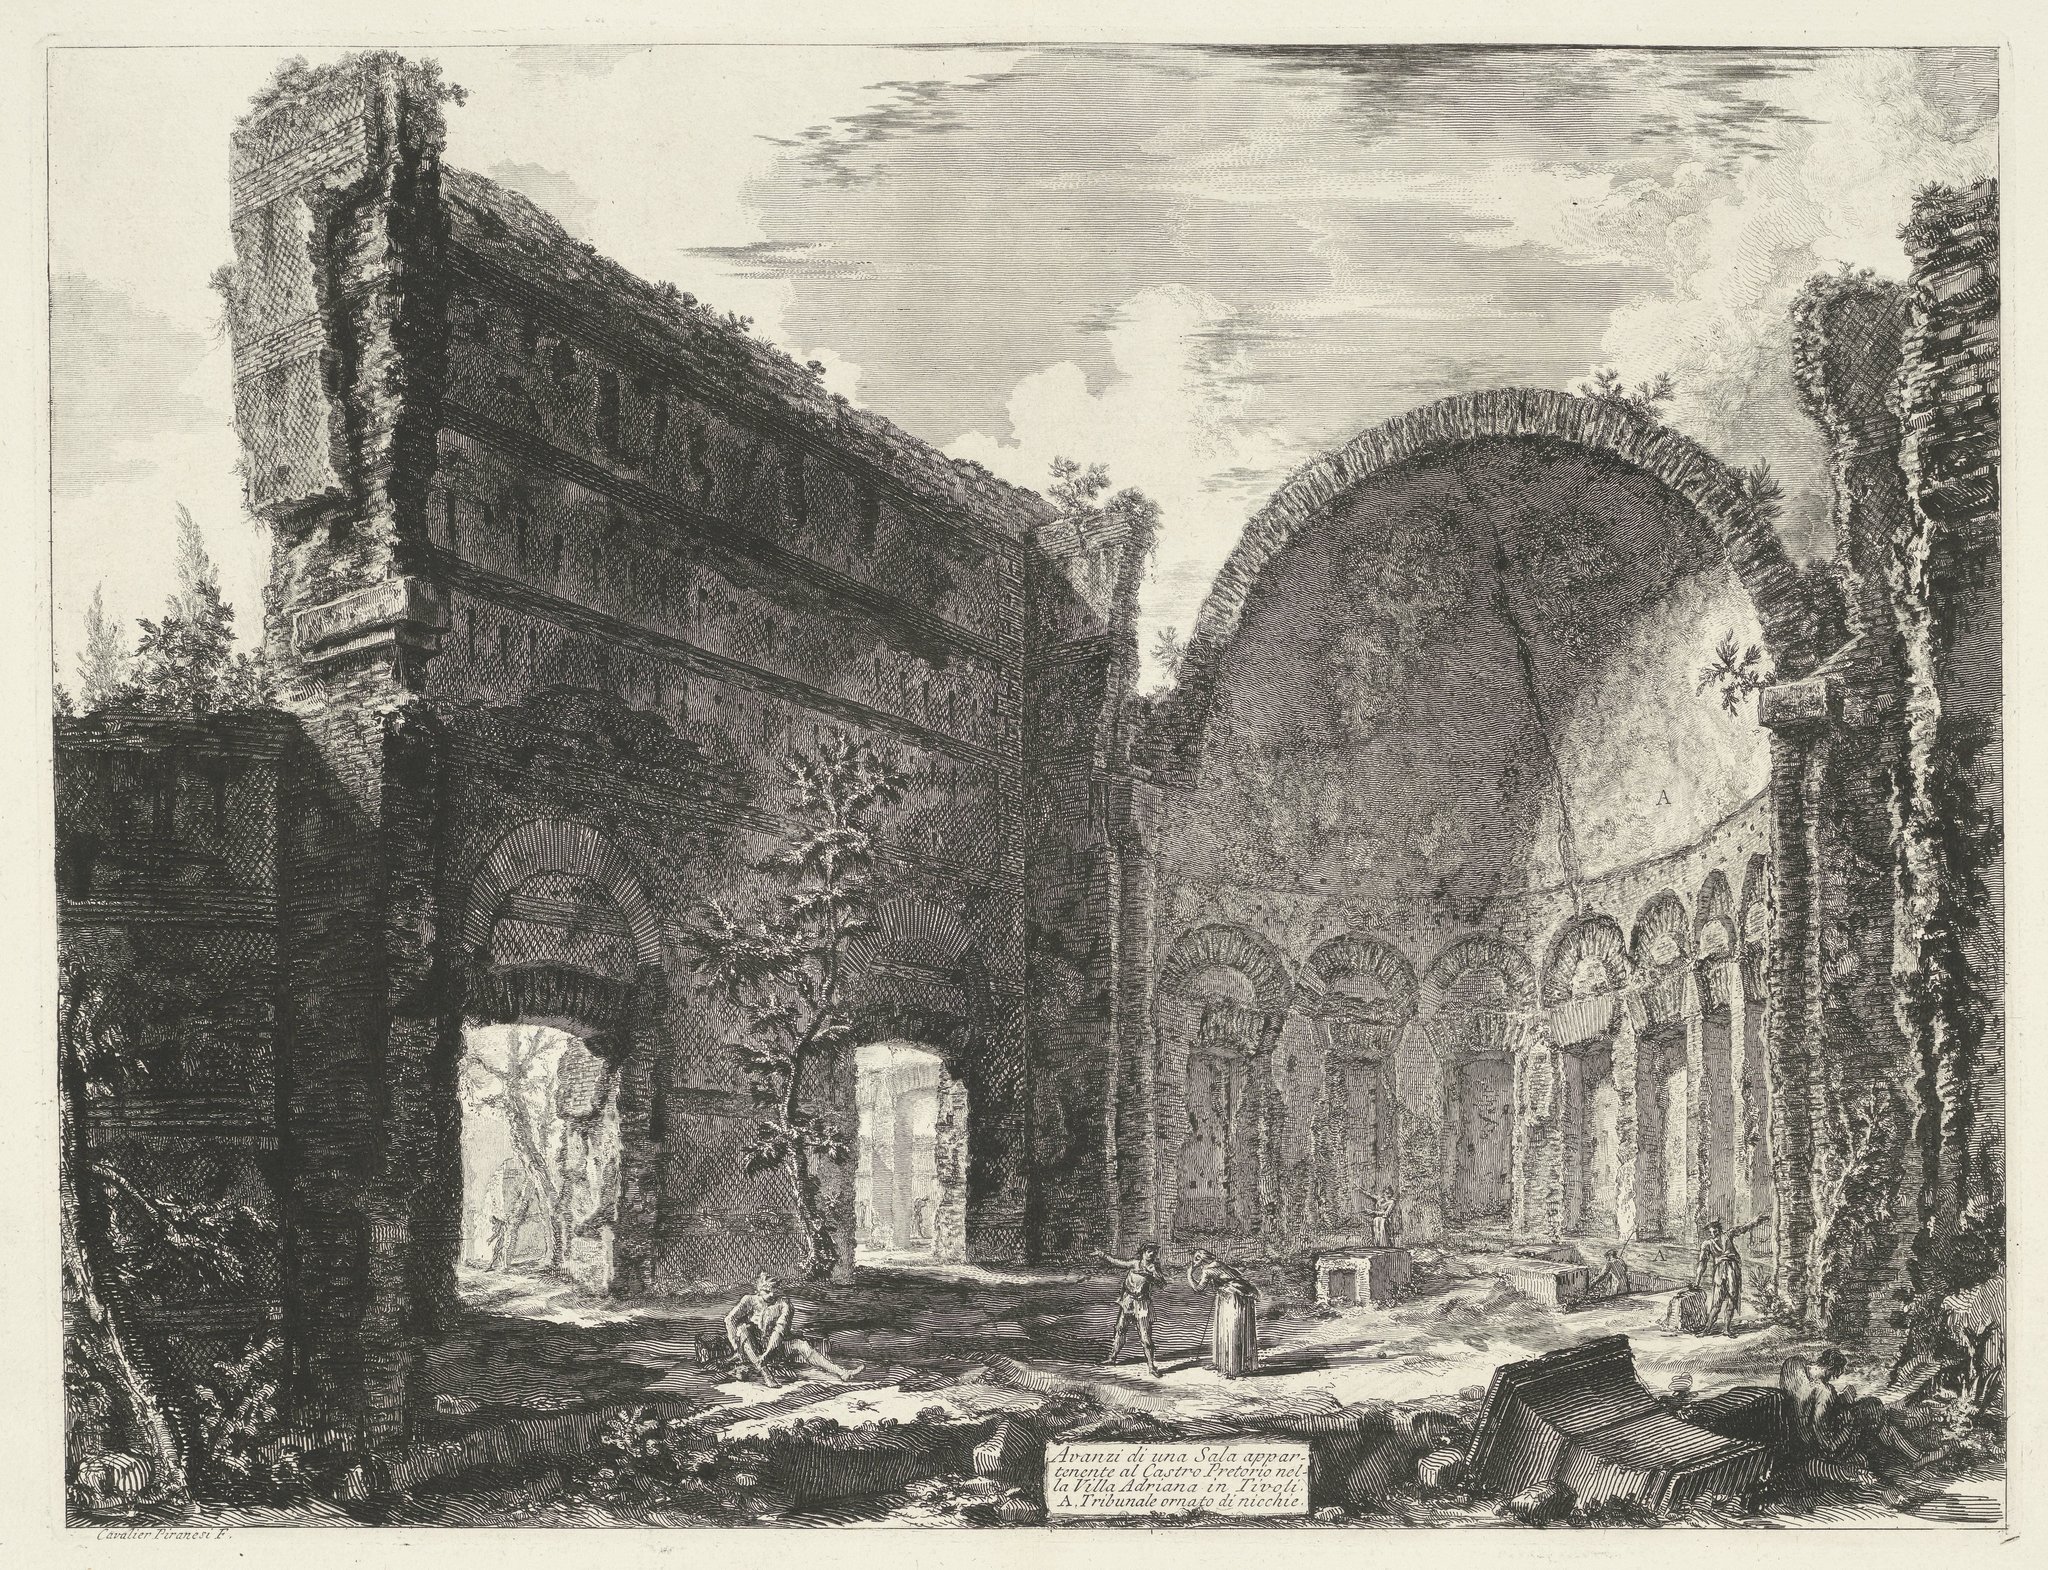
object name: print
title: Gezichten op Rome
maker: giovanni battista piranesi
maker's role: designer, draughtsman, print maker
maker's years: 1720-1778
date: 1748-1778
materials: paper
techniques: etching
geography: rome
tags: ruin of a building ~ architecture, landscape with ruins, study; 'studiolo'; library, villa, tivoli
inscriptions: collector's mark: Lugt 2228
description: Deze prent maakt deel uit van de serie 'Vedute di Roma'. Piranesi werkte aan deze 135 platen tellende serie tussen 1748 en zijn dood in 1778. Francesco Piranesi voegde later nog twee prenten toe aan de reeks van zijn vader.